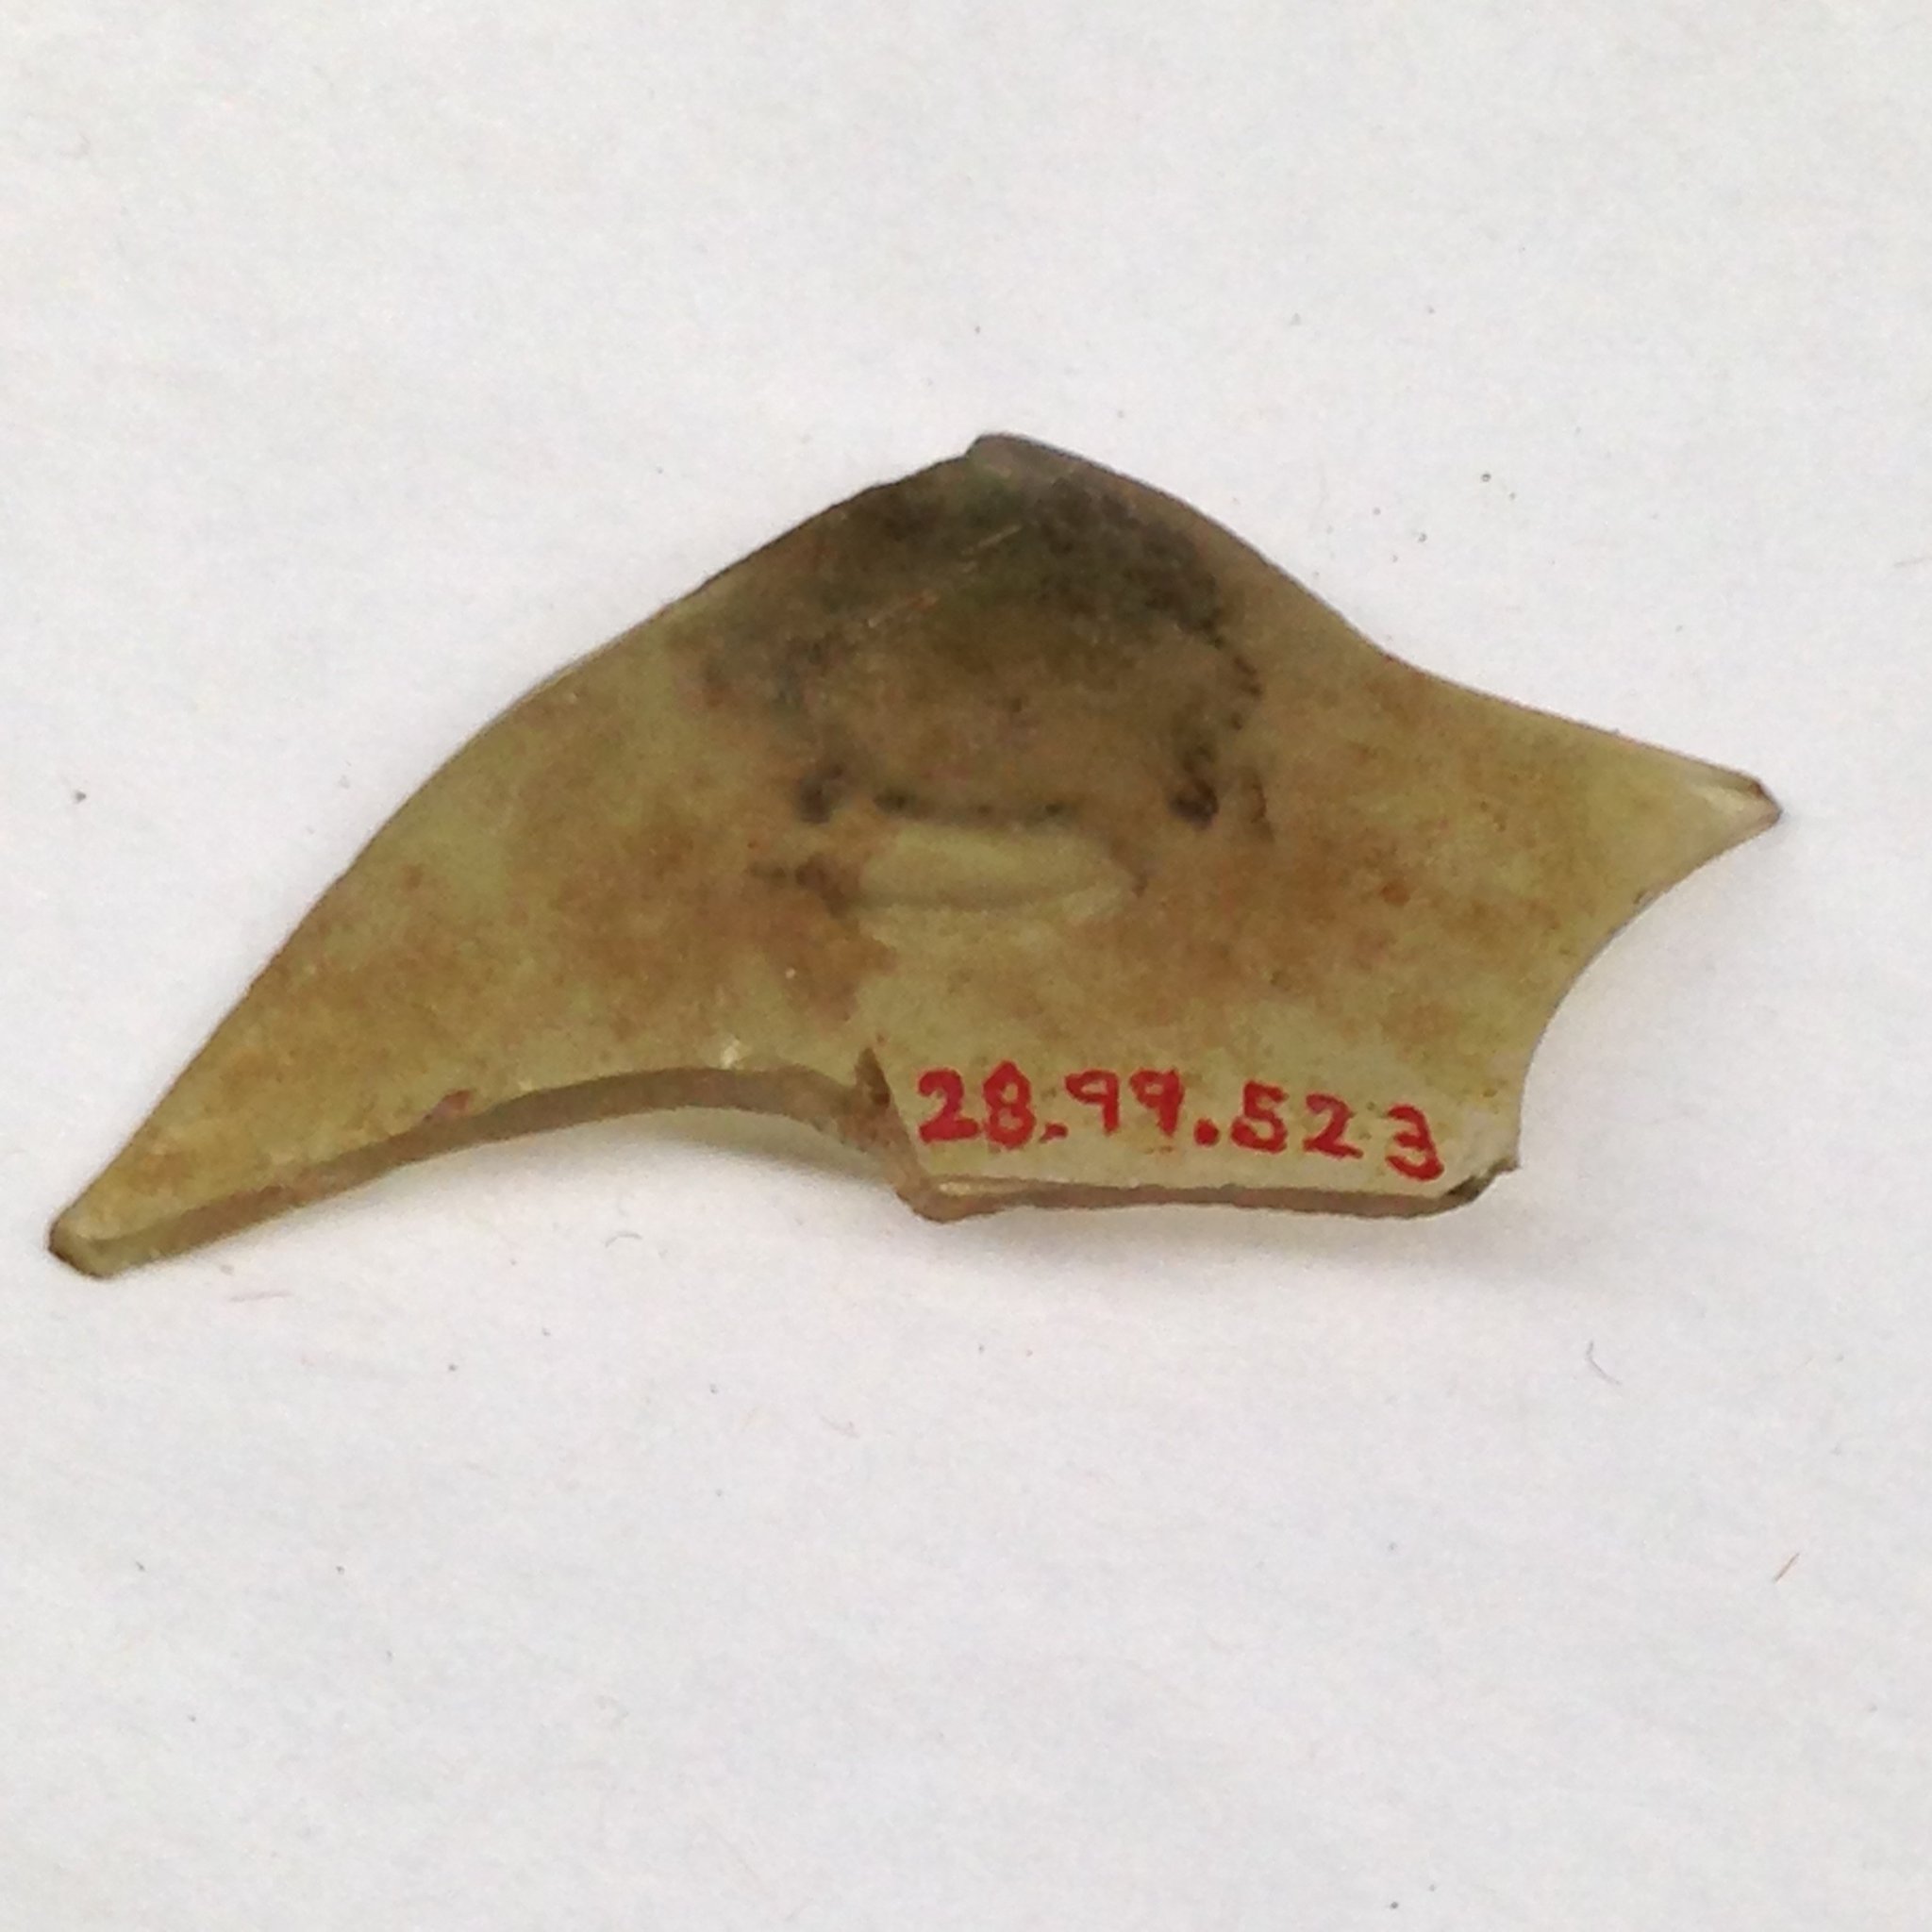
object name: fragment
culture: european or middle eastern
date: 1150-1250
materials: ceramic, glass